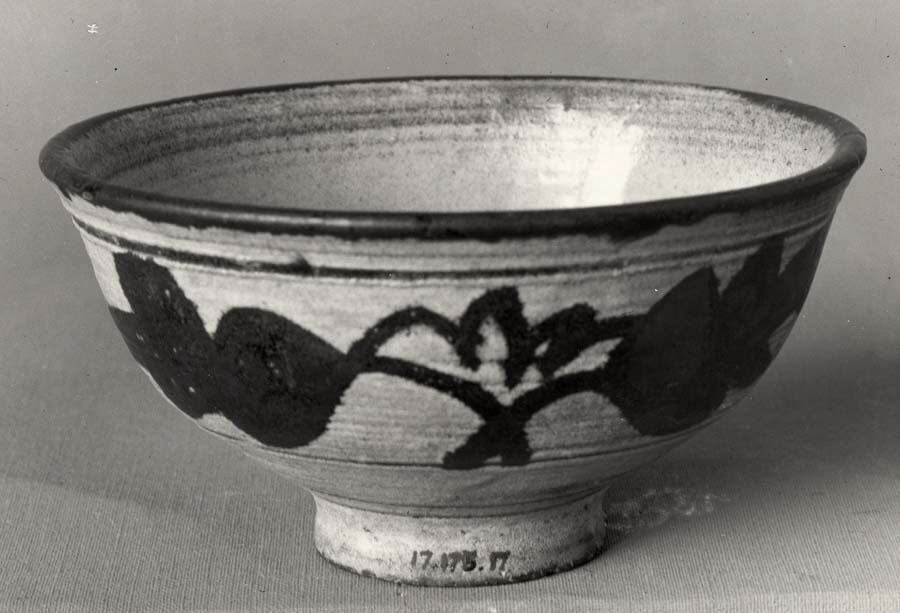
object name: bowl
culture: korean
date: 1401-1500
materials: glaze, stoneware